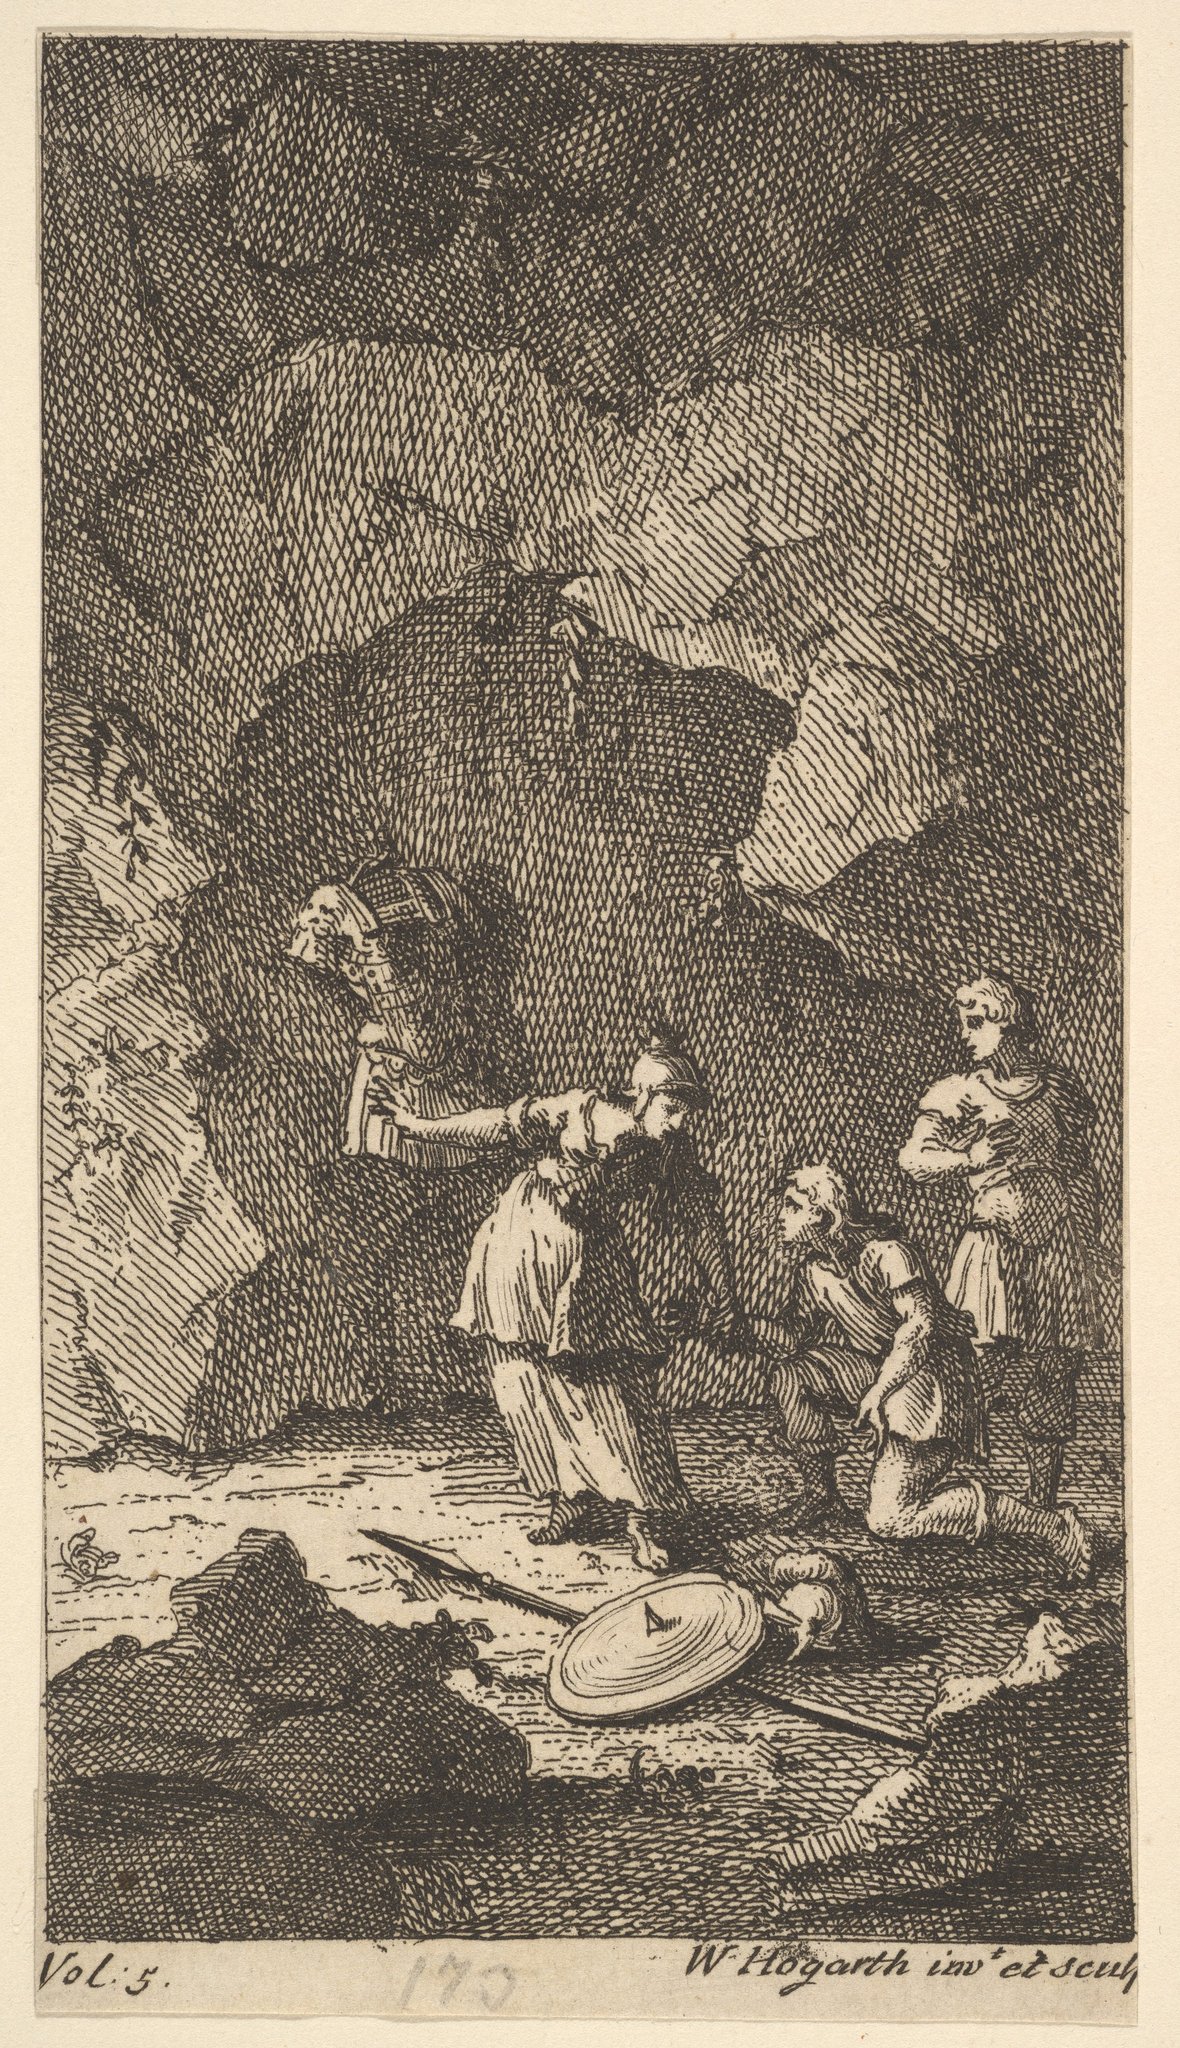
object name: print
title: Cassandra, Frontispiece, Vol. 5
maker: william hogarth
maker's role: artist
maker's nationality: british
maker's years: 1697-1764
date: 1725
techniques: engraving, etching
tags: weapons,men,women